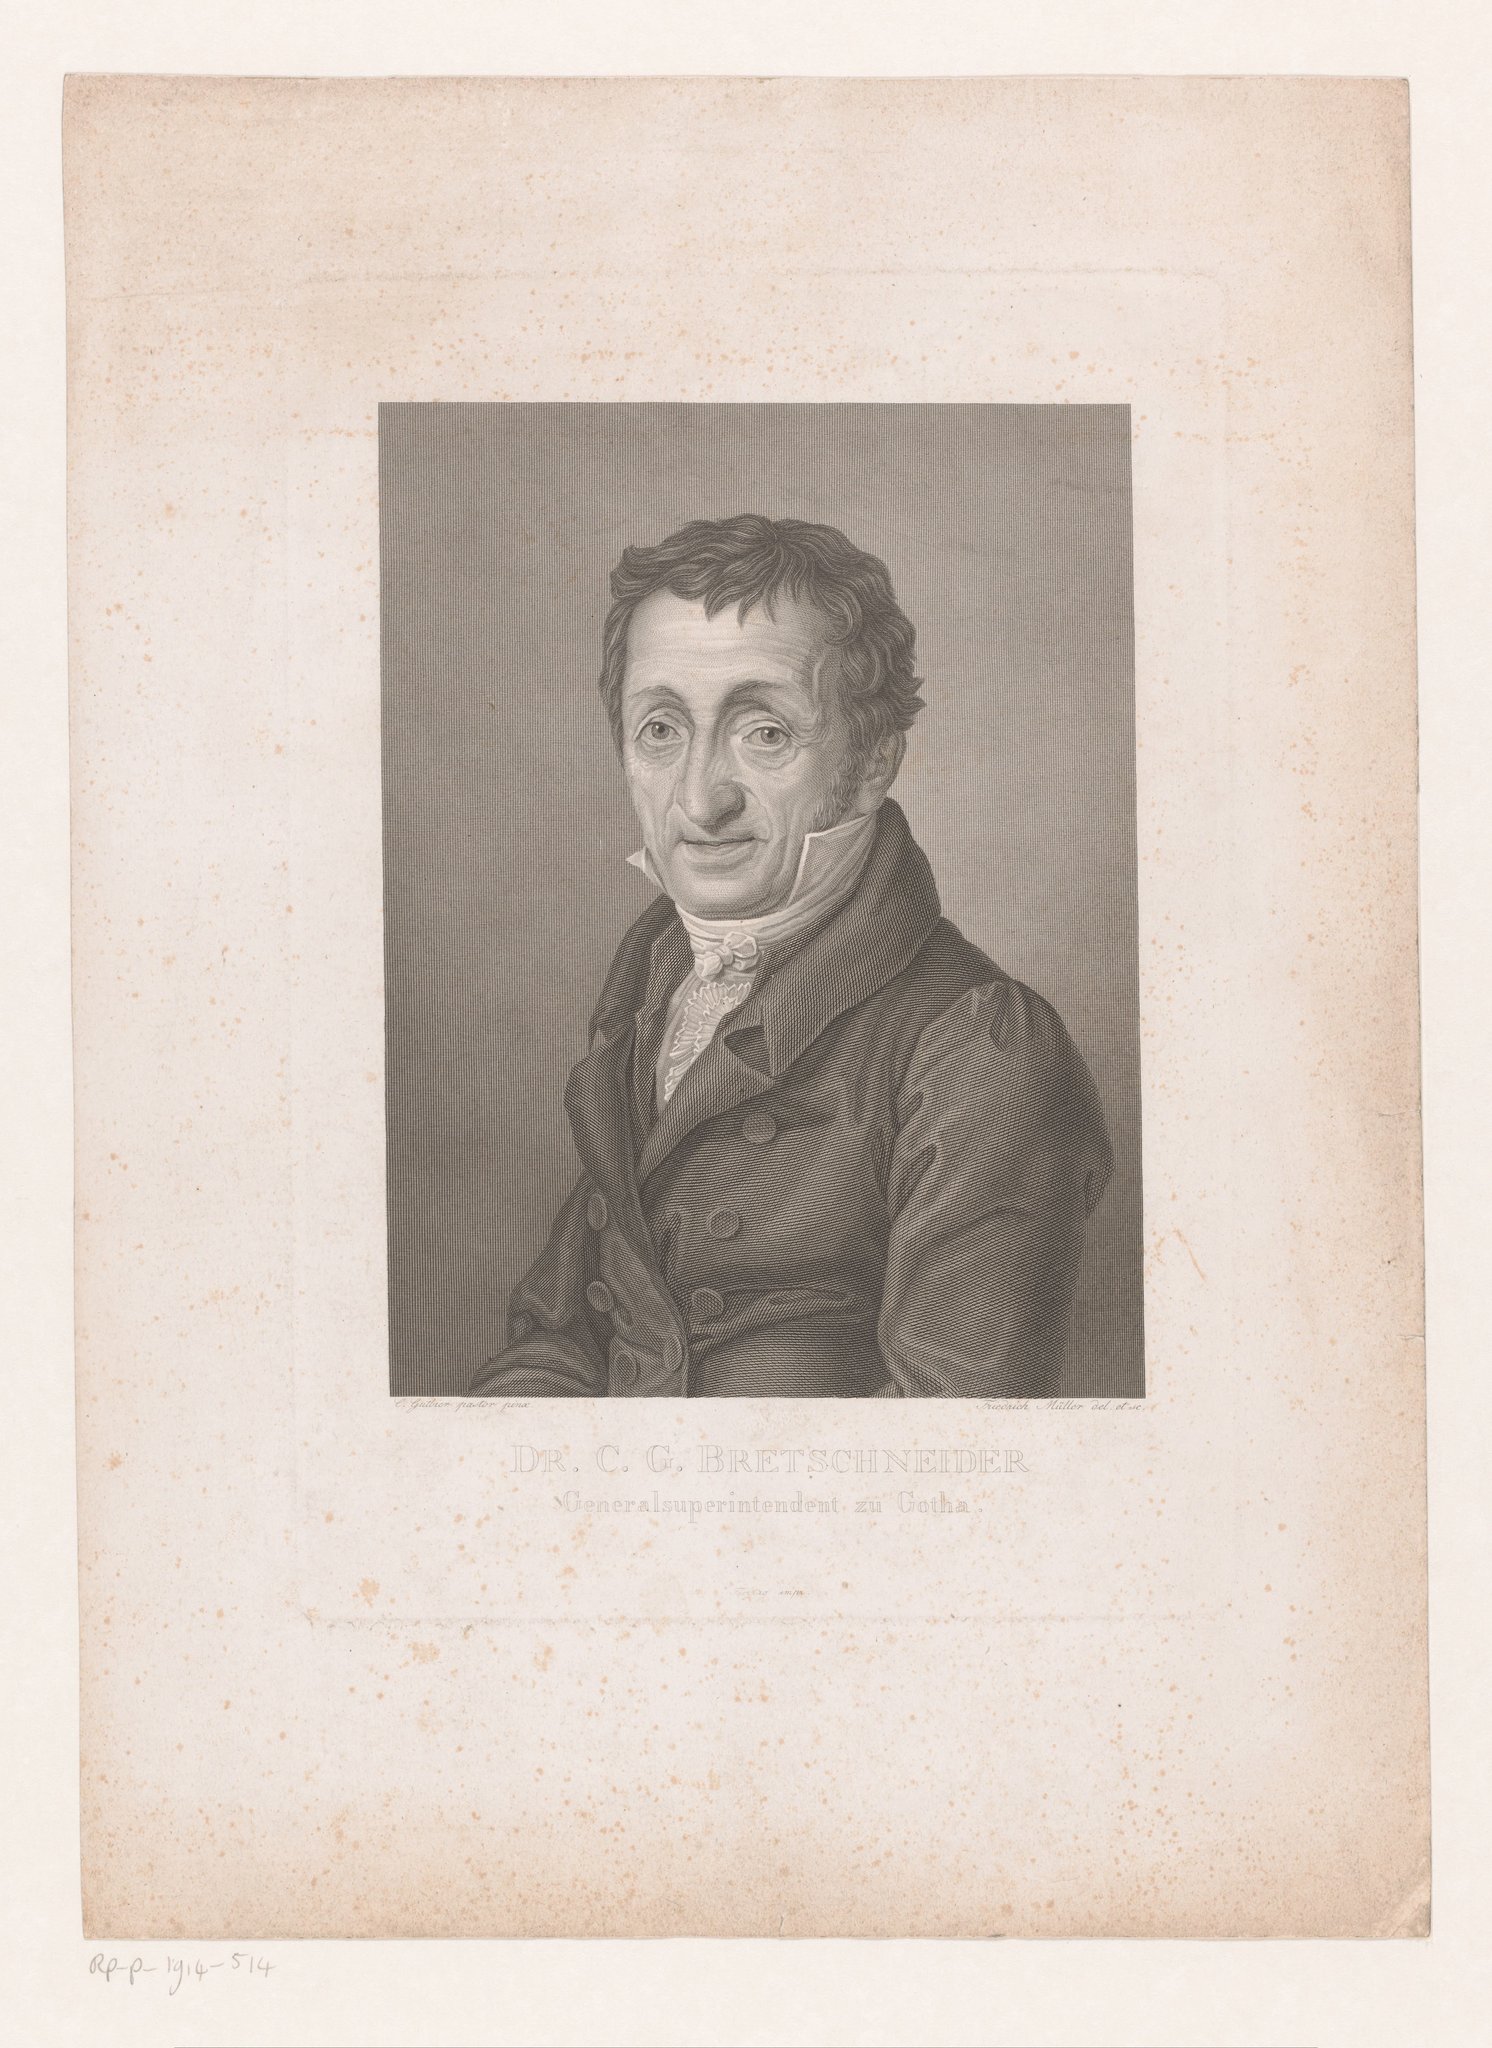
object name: print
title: Portret van Karl Gottlieb Bretschneider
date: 1792-1816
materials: paper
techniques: engraving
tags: zwickau, historical persons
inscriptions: collector's mark: Lugt 2228